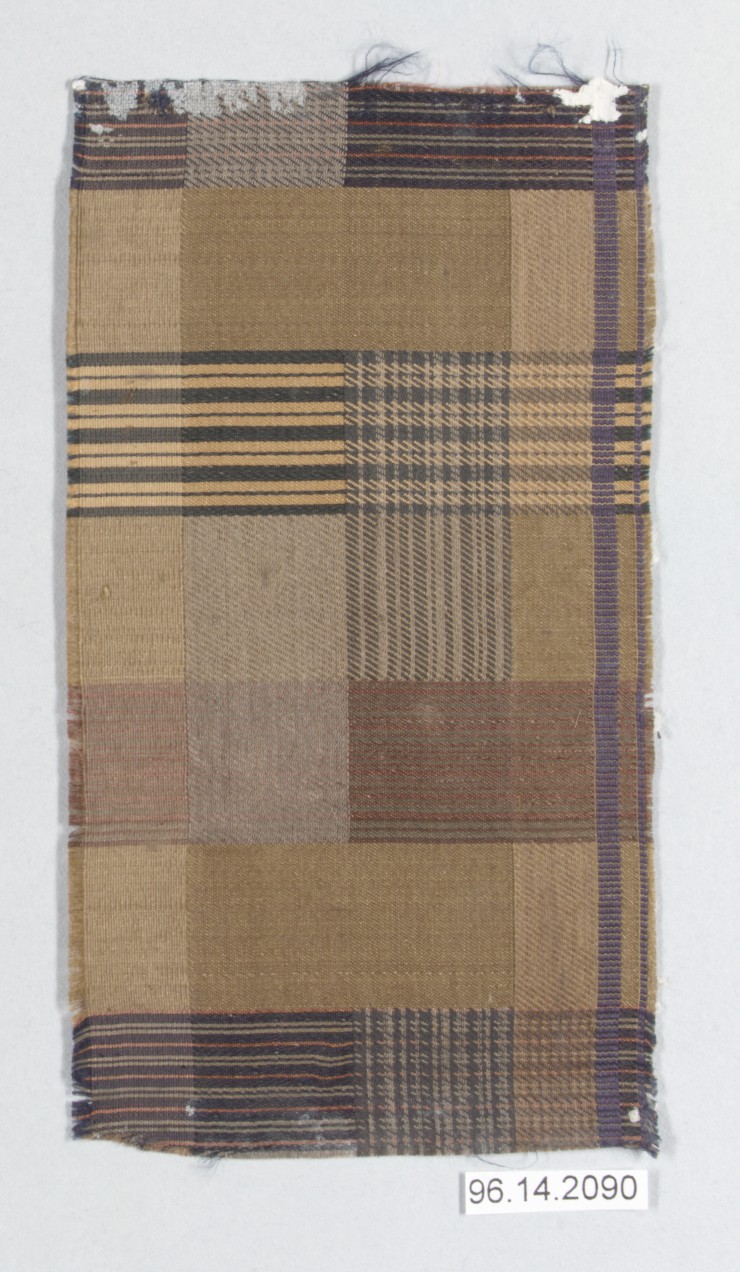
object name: piece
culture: japanese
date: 1701-1900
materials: silk